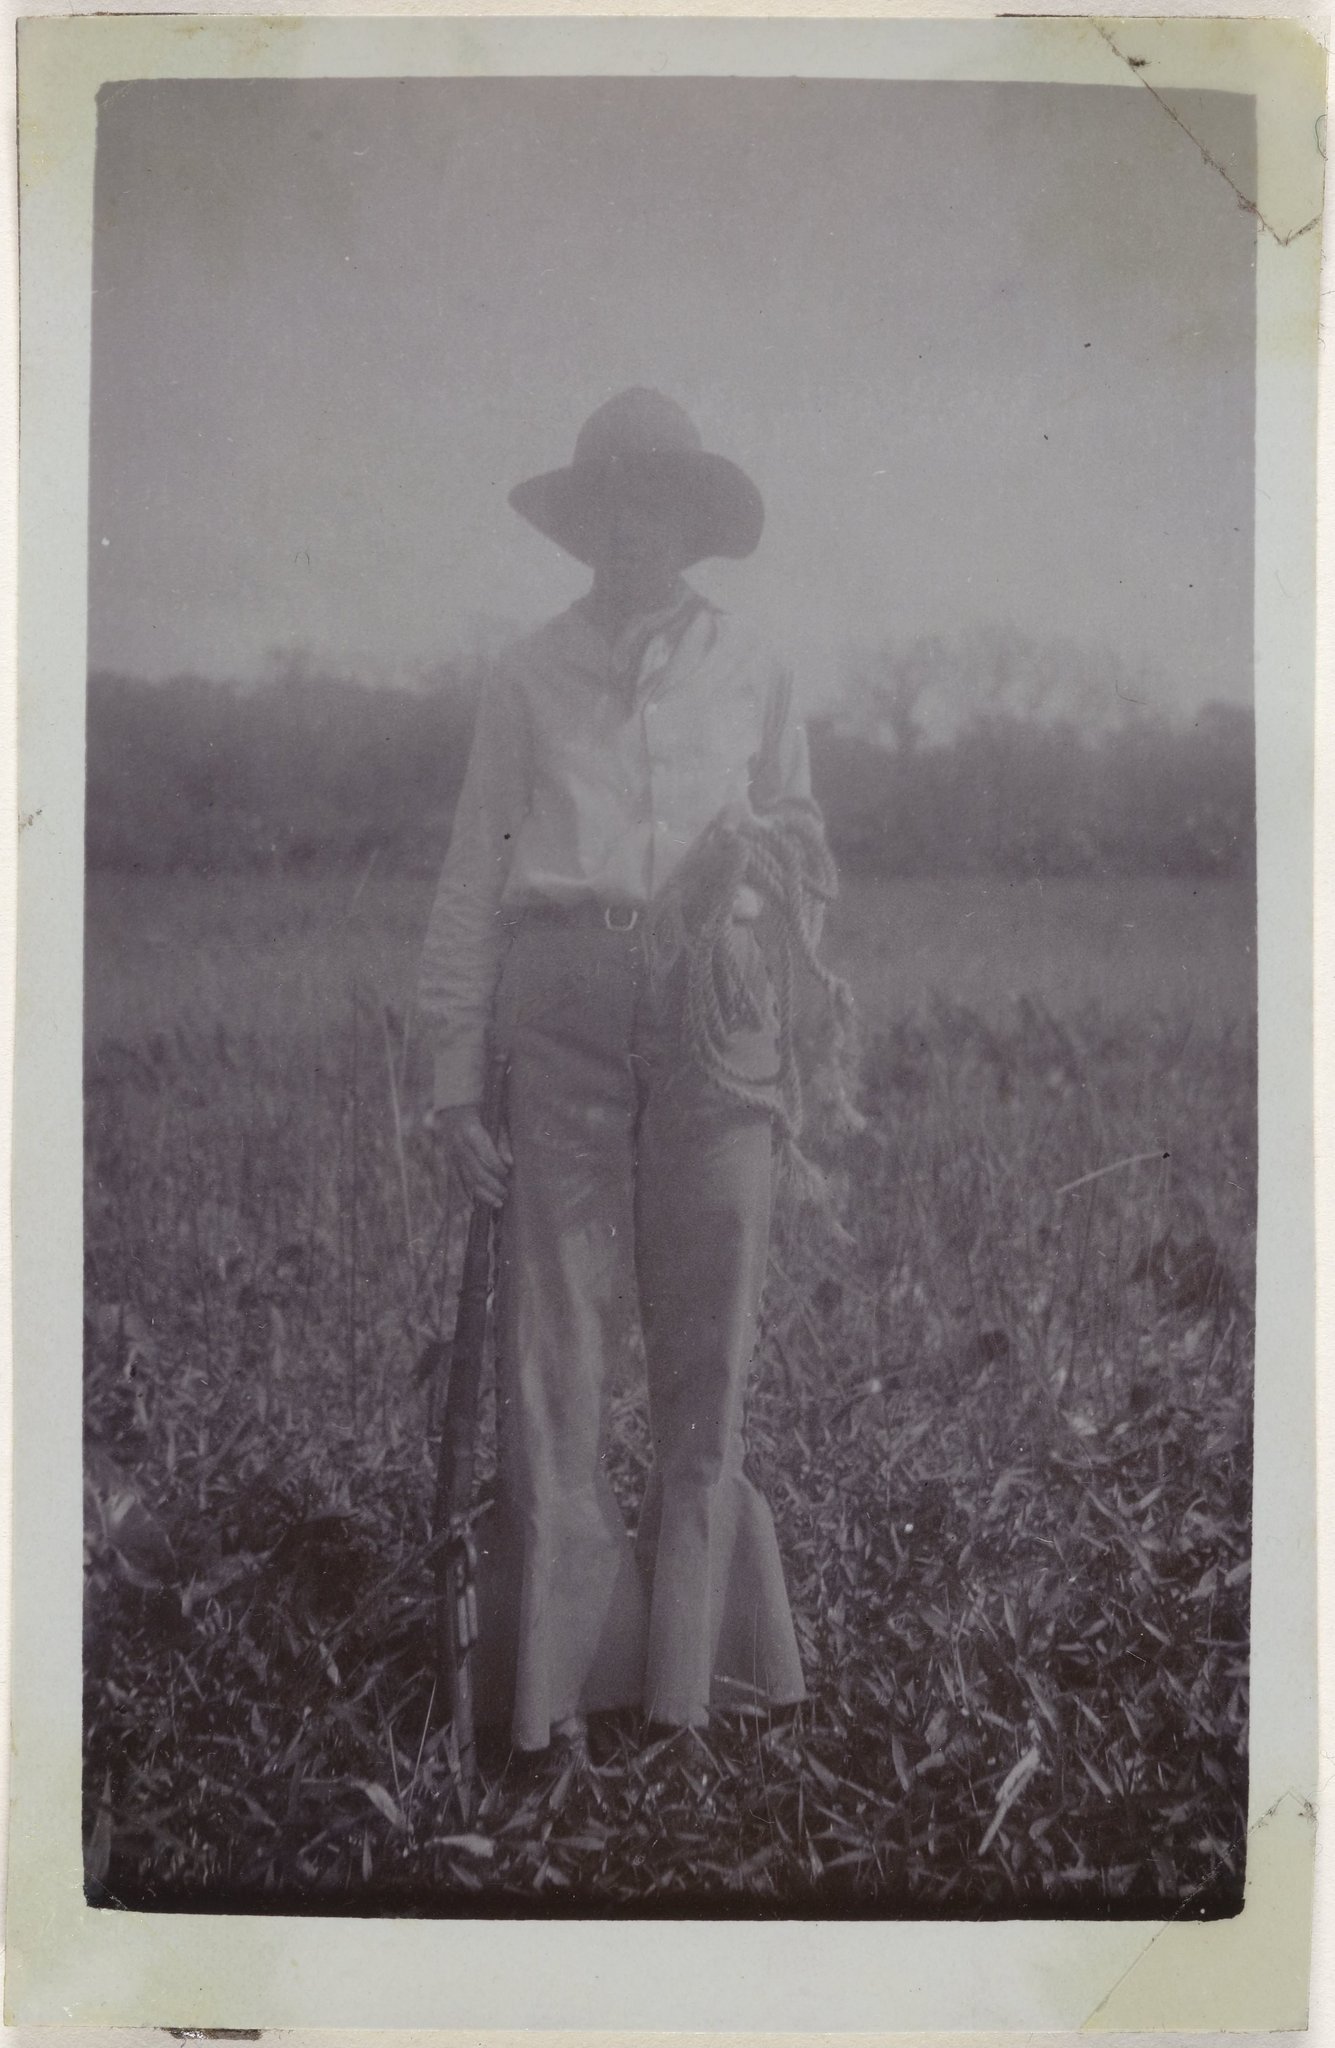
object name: photograph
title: Doortje Brouwers klaar voor de jacht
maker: Anonymous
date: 1910-1931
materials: photographic support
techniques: photography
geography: suriname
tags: amsterdam, theodoor brouwers, suriname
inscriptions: inscription: ‘Accaribo Okt "31’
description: In de periode 1911-1932 woonde op plantage Accaribo in Suriname de familie Brouwers van wie de foto's afkomstig zijn. Rond 1910 vond Theodoor Brouwers werk op plantage Accaribo. In 1929 werd hij eigenaar van de plantage.